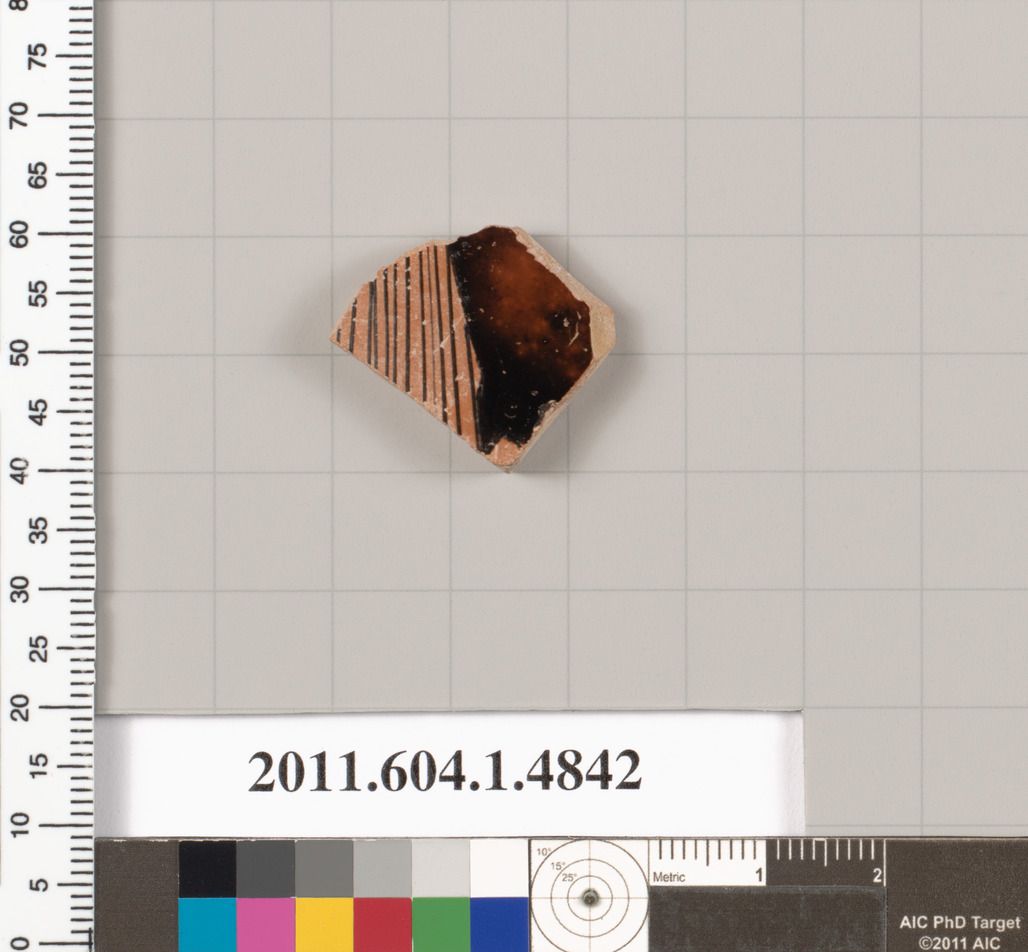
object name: kylix fragment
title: Terracotta fragment of a kylix (drinking cup)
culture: greek, attic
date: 490-480 BCE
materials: terracotta